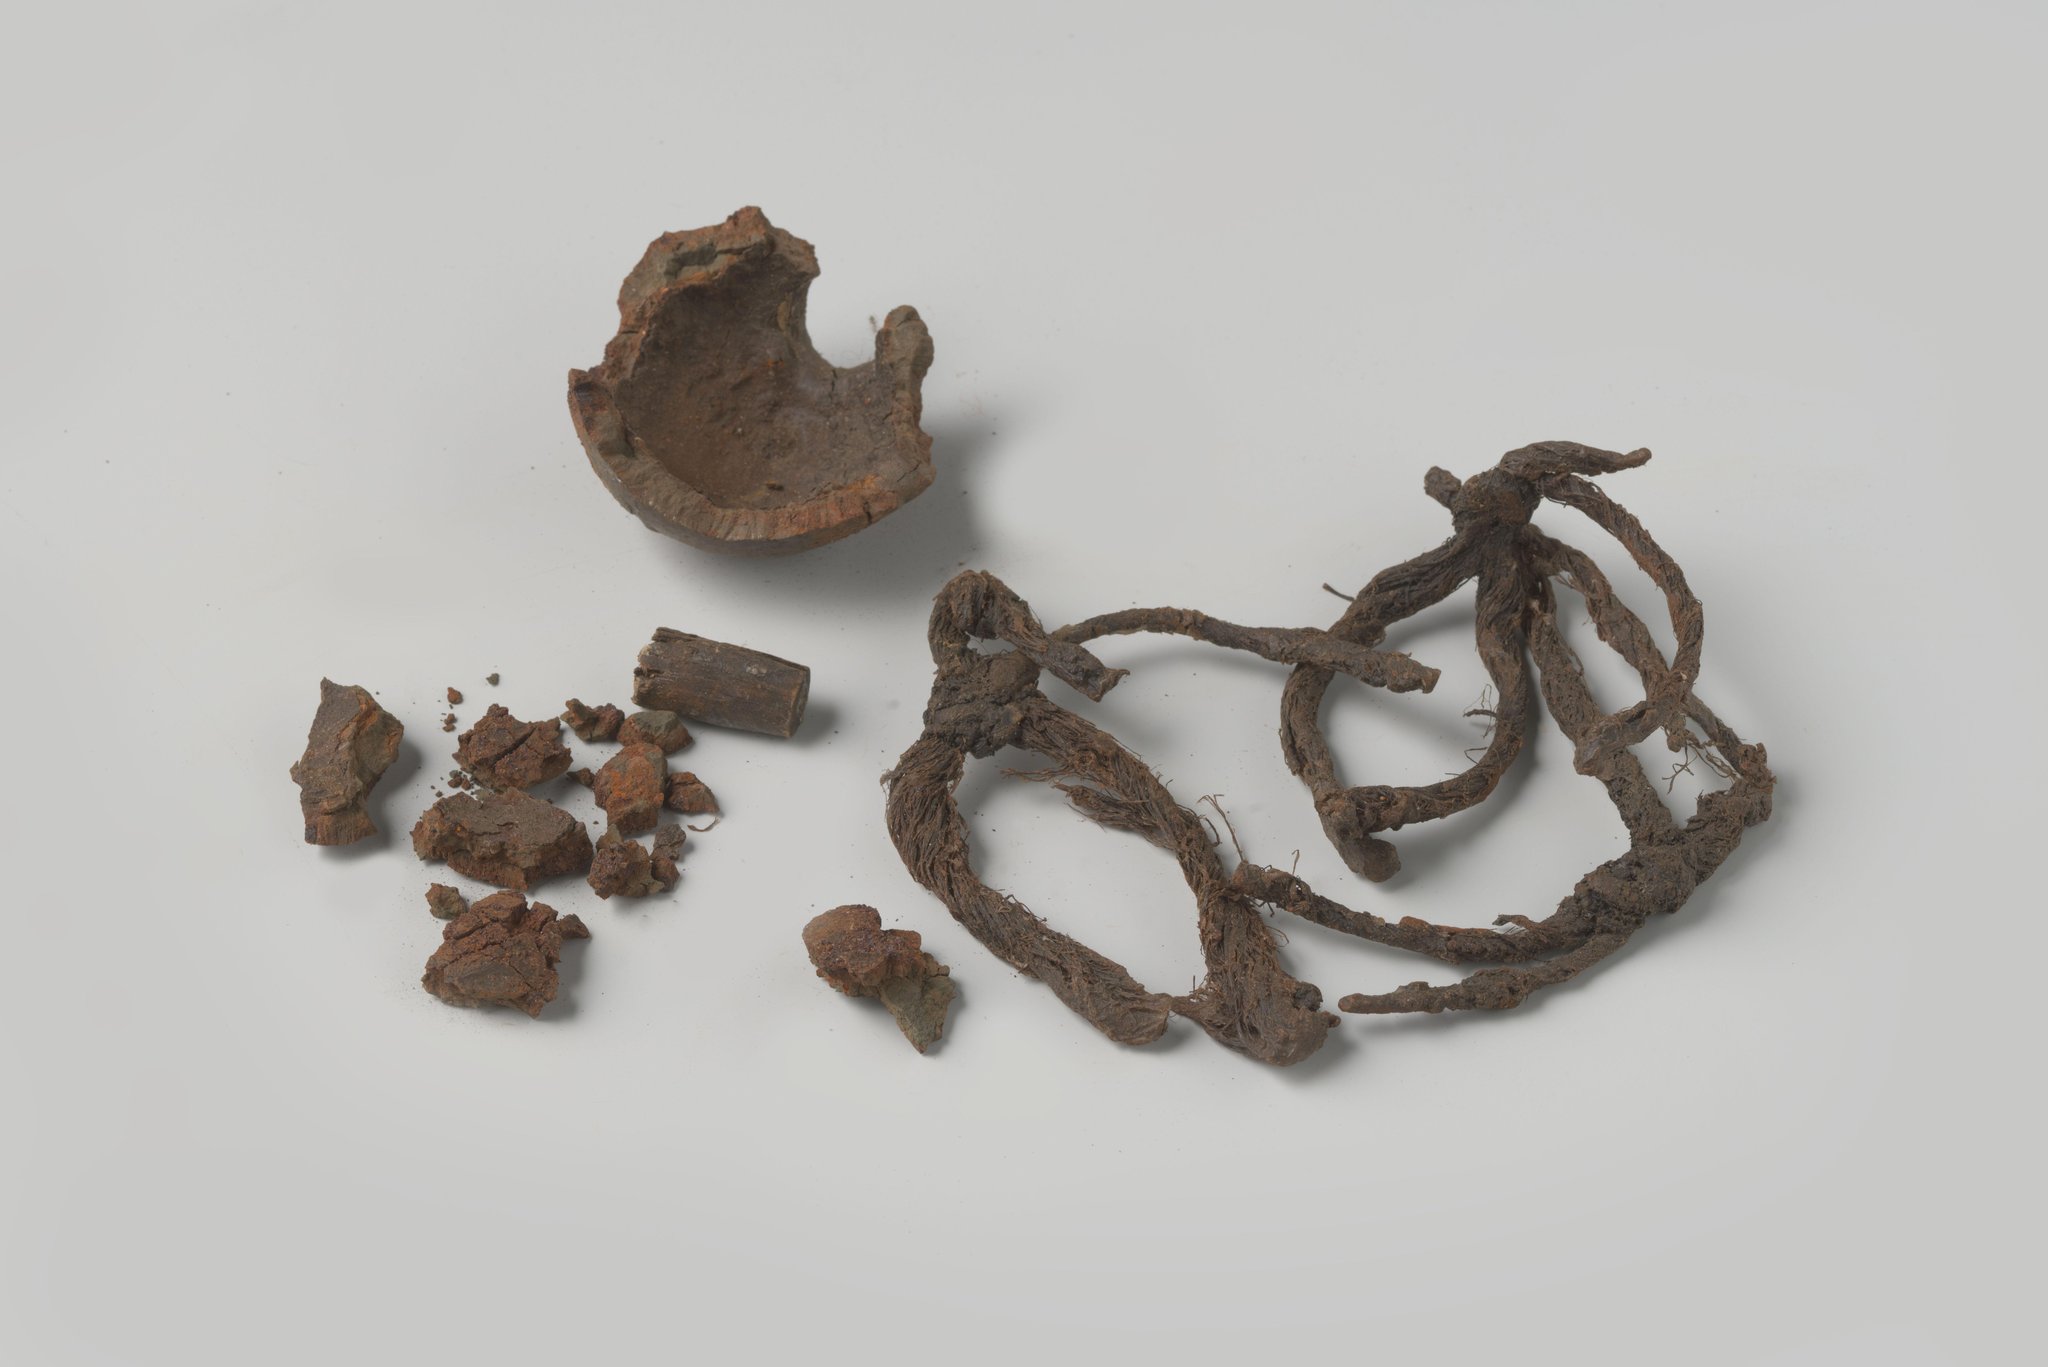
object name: hand grenade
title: Gefragmenteerde handgranaat, touw en houtfragment uit het wrak van de Oostindiëvaarder Hollandia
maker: Anonymous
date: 1700-1743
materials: iron, fiber, wood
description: Gefragmenteerde handgranaat, touw en houtfragment.